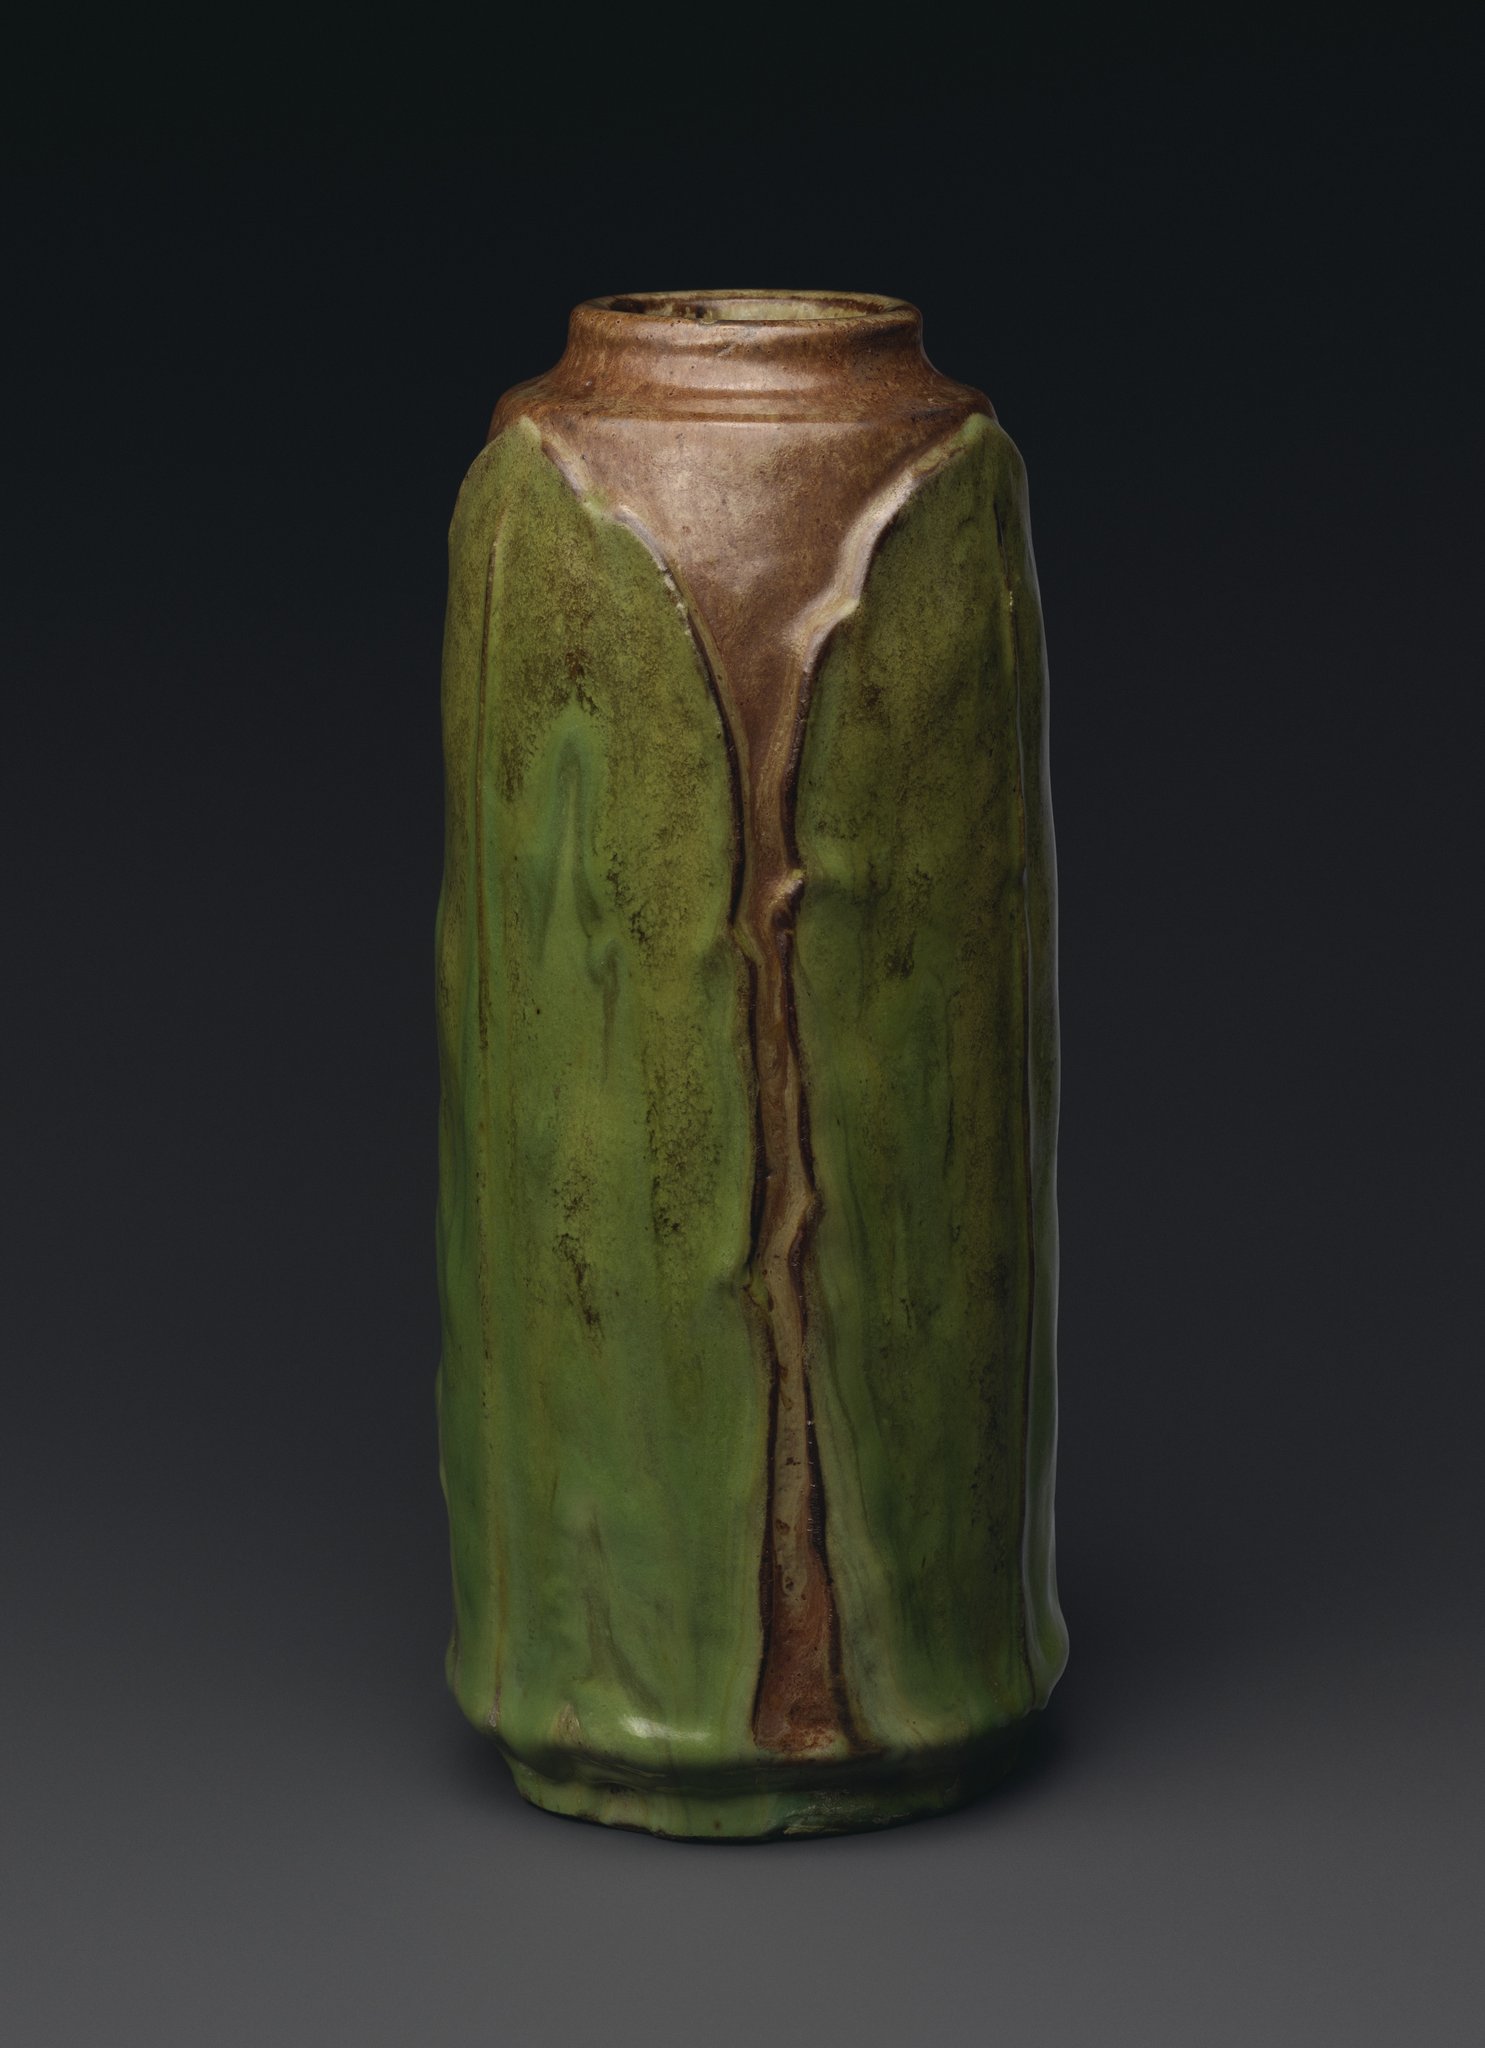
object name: vase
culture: american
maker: william j. walley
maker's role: maker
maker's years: 1852-1919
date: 1898-1918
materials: earthenware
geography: united states